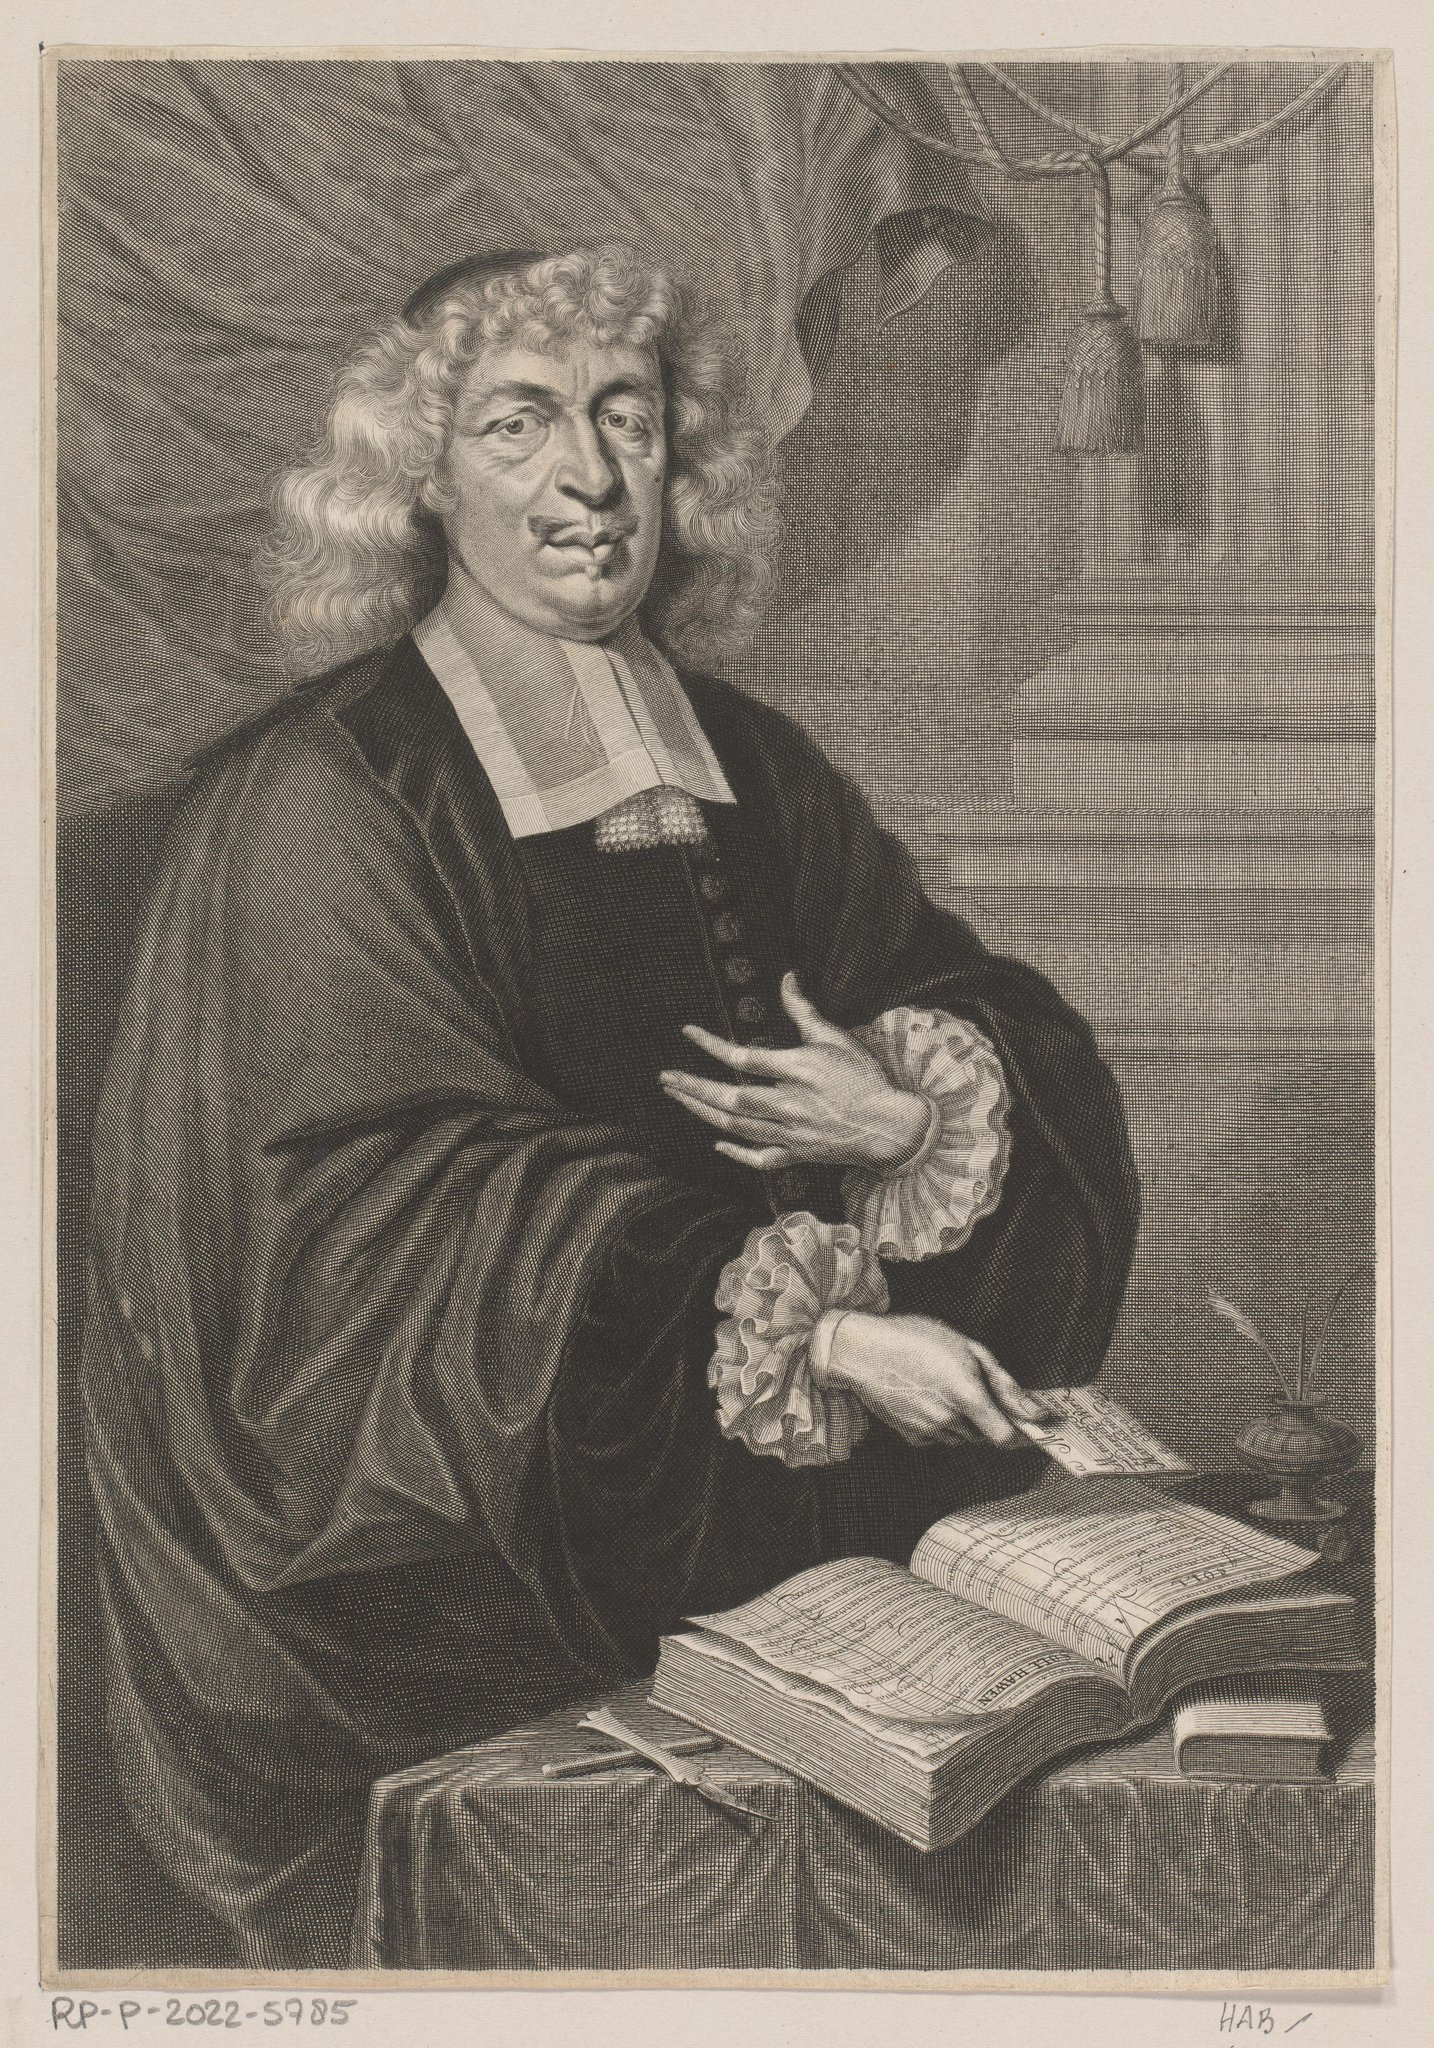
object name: print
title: Portret van Jean Friderich Wirtz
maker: Anonymous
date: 1670-1720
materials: paper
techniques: engraving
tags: historical persons, book